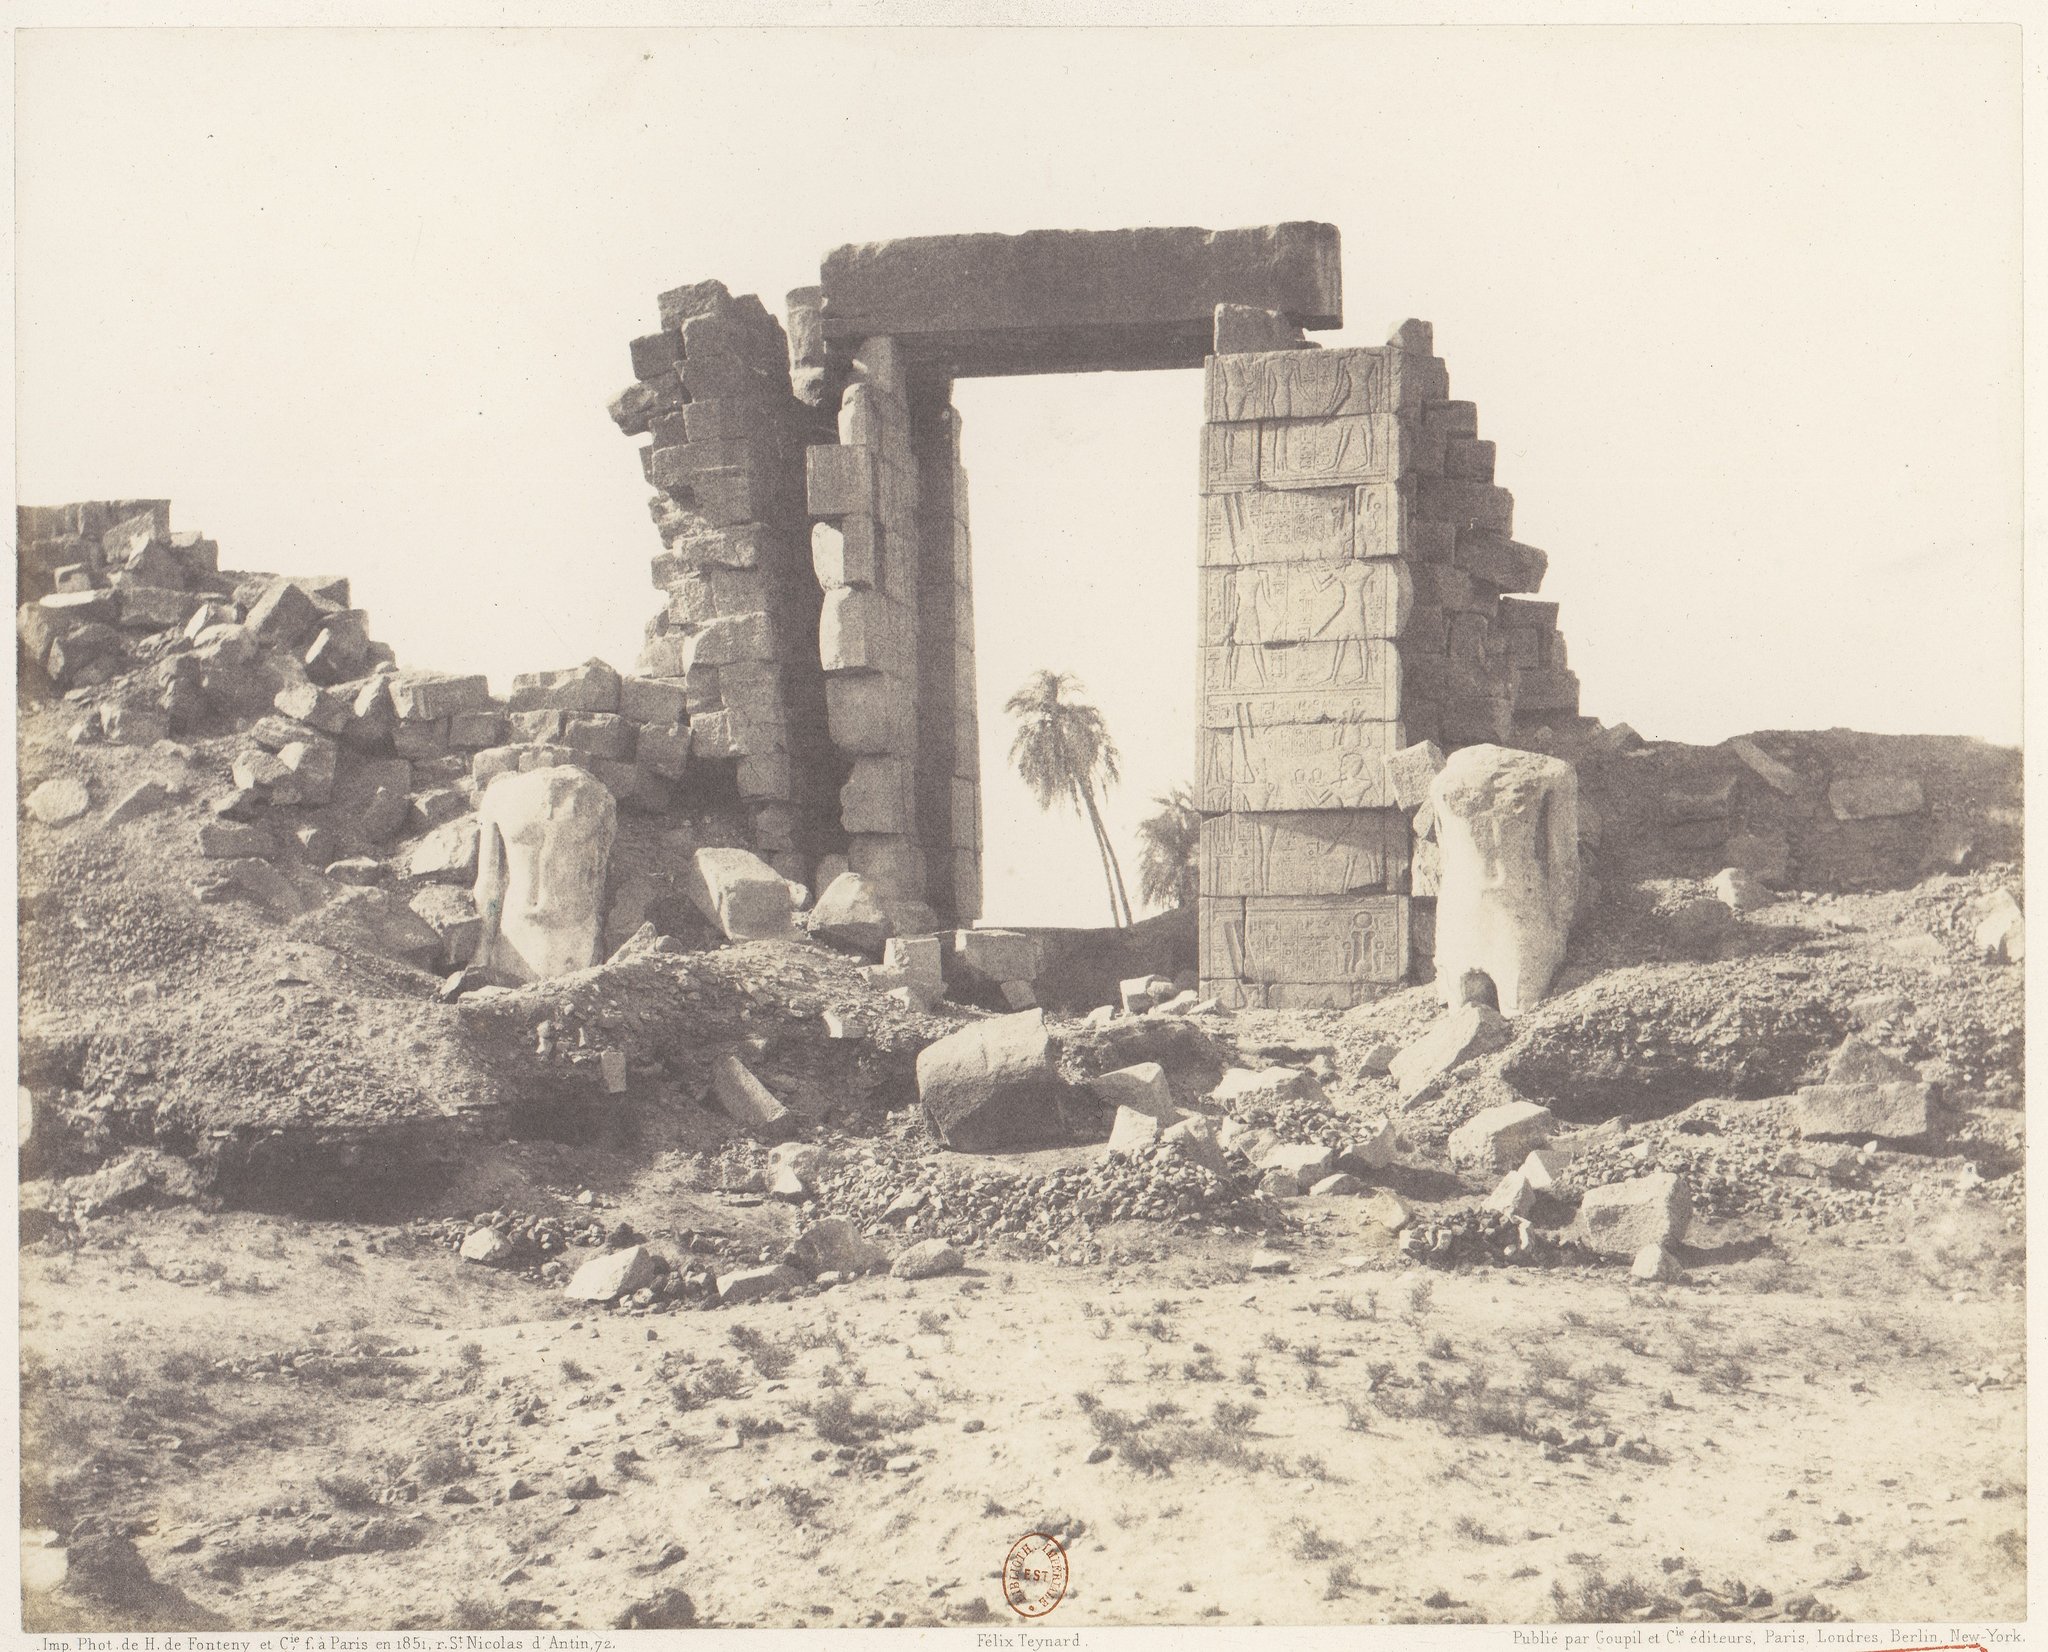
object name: photograph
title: Karnak (Thèbes), Premier Pylône - Ruines de la Porte et des Colosses, Vues du Point E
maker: félix teynard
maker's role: artist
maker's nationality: french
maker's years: 1817-1892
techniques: paper negative, salted paper print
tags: architecture,ruins